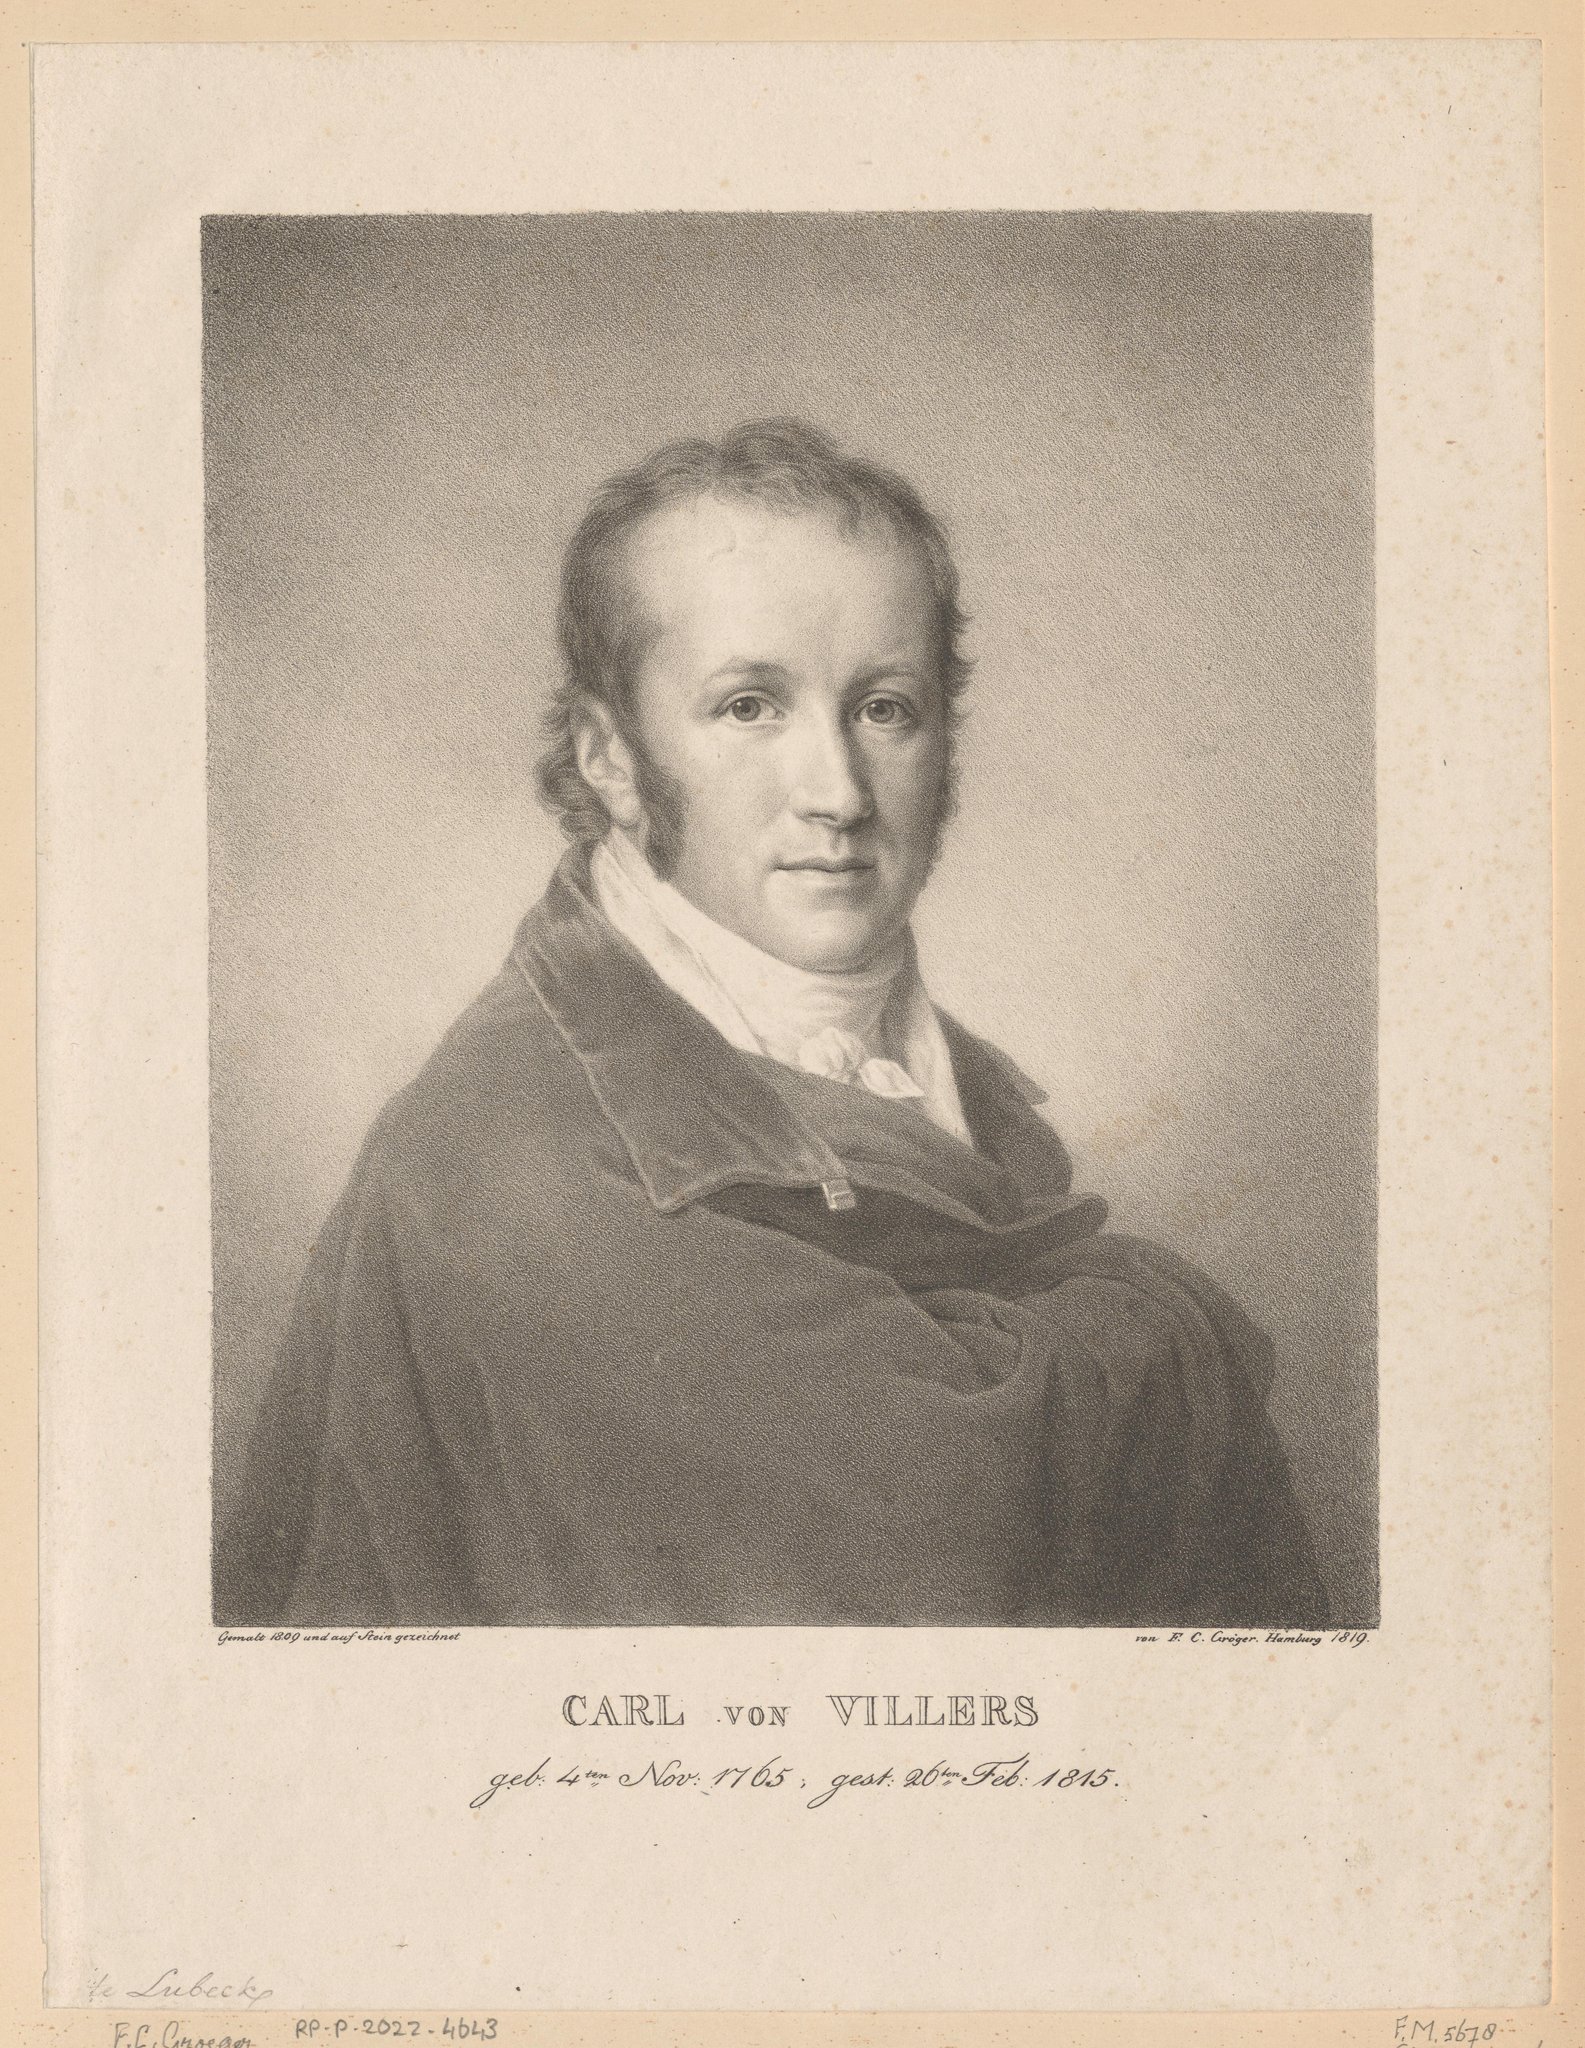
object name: print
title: Portret van Charles de Villers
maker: friedrich carl gröger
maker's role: draughtsman, painter, print maker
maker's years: 1766-1838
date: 1819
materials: paper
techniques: lithograph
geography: hamburg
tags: scholar, philosopher, historical persons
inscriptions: collector's mark: Lugt 2228